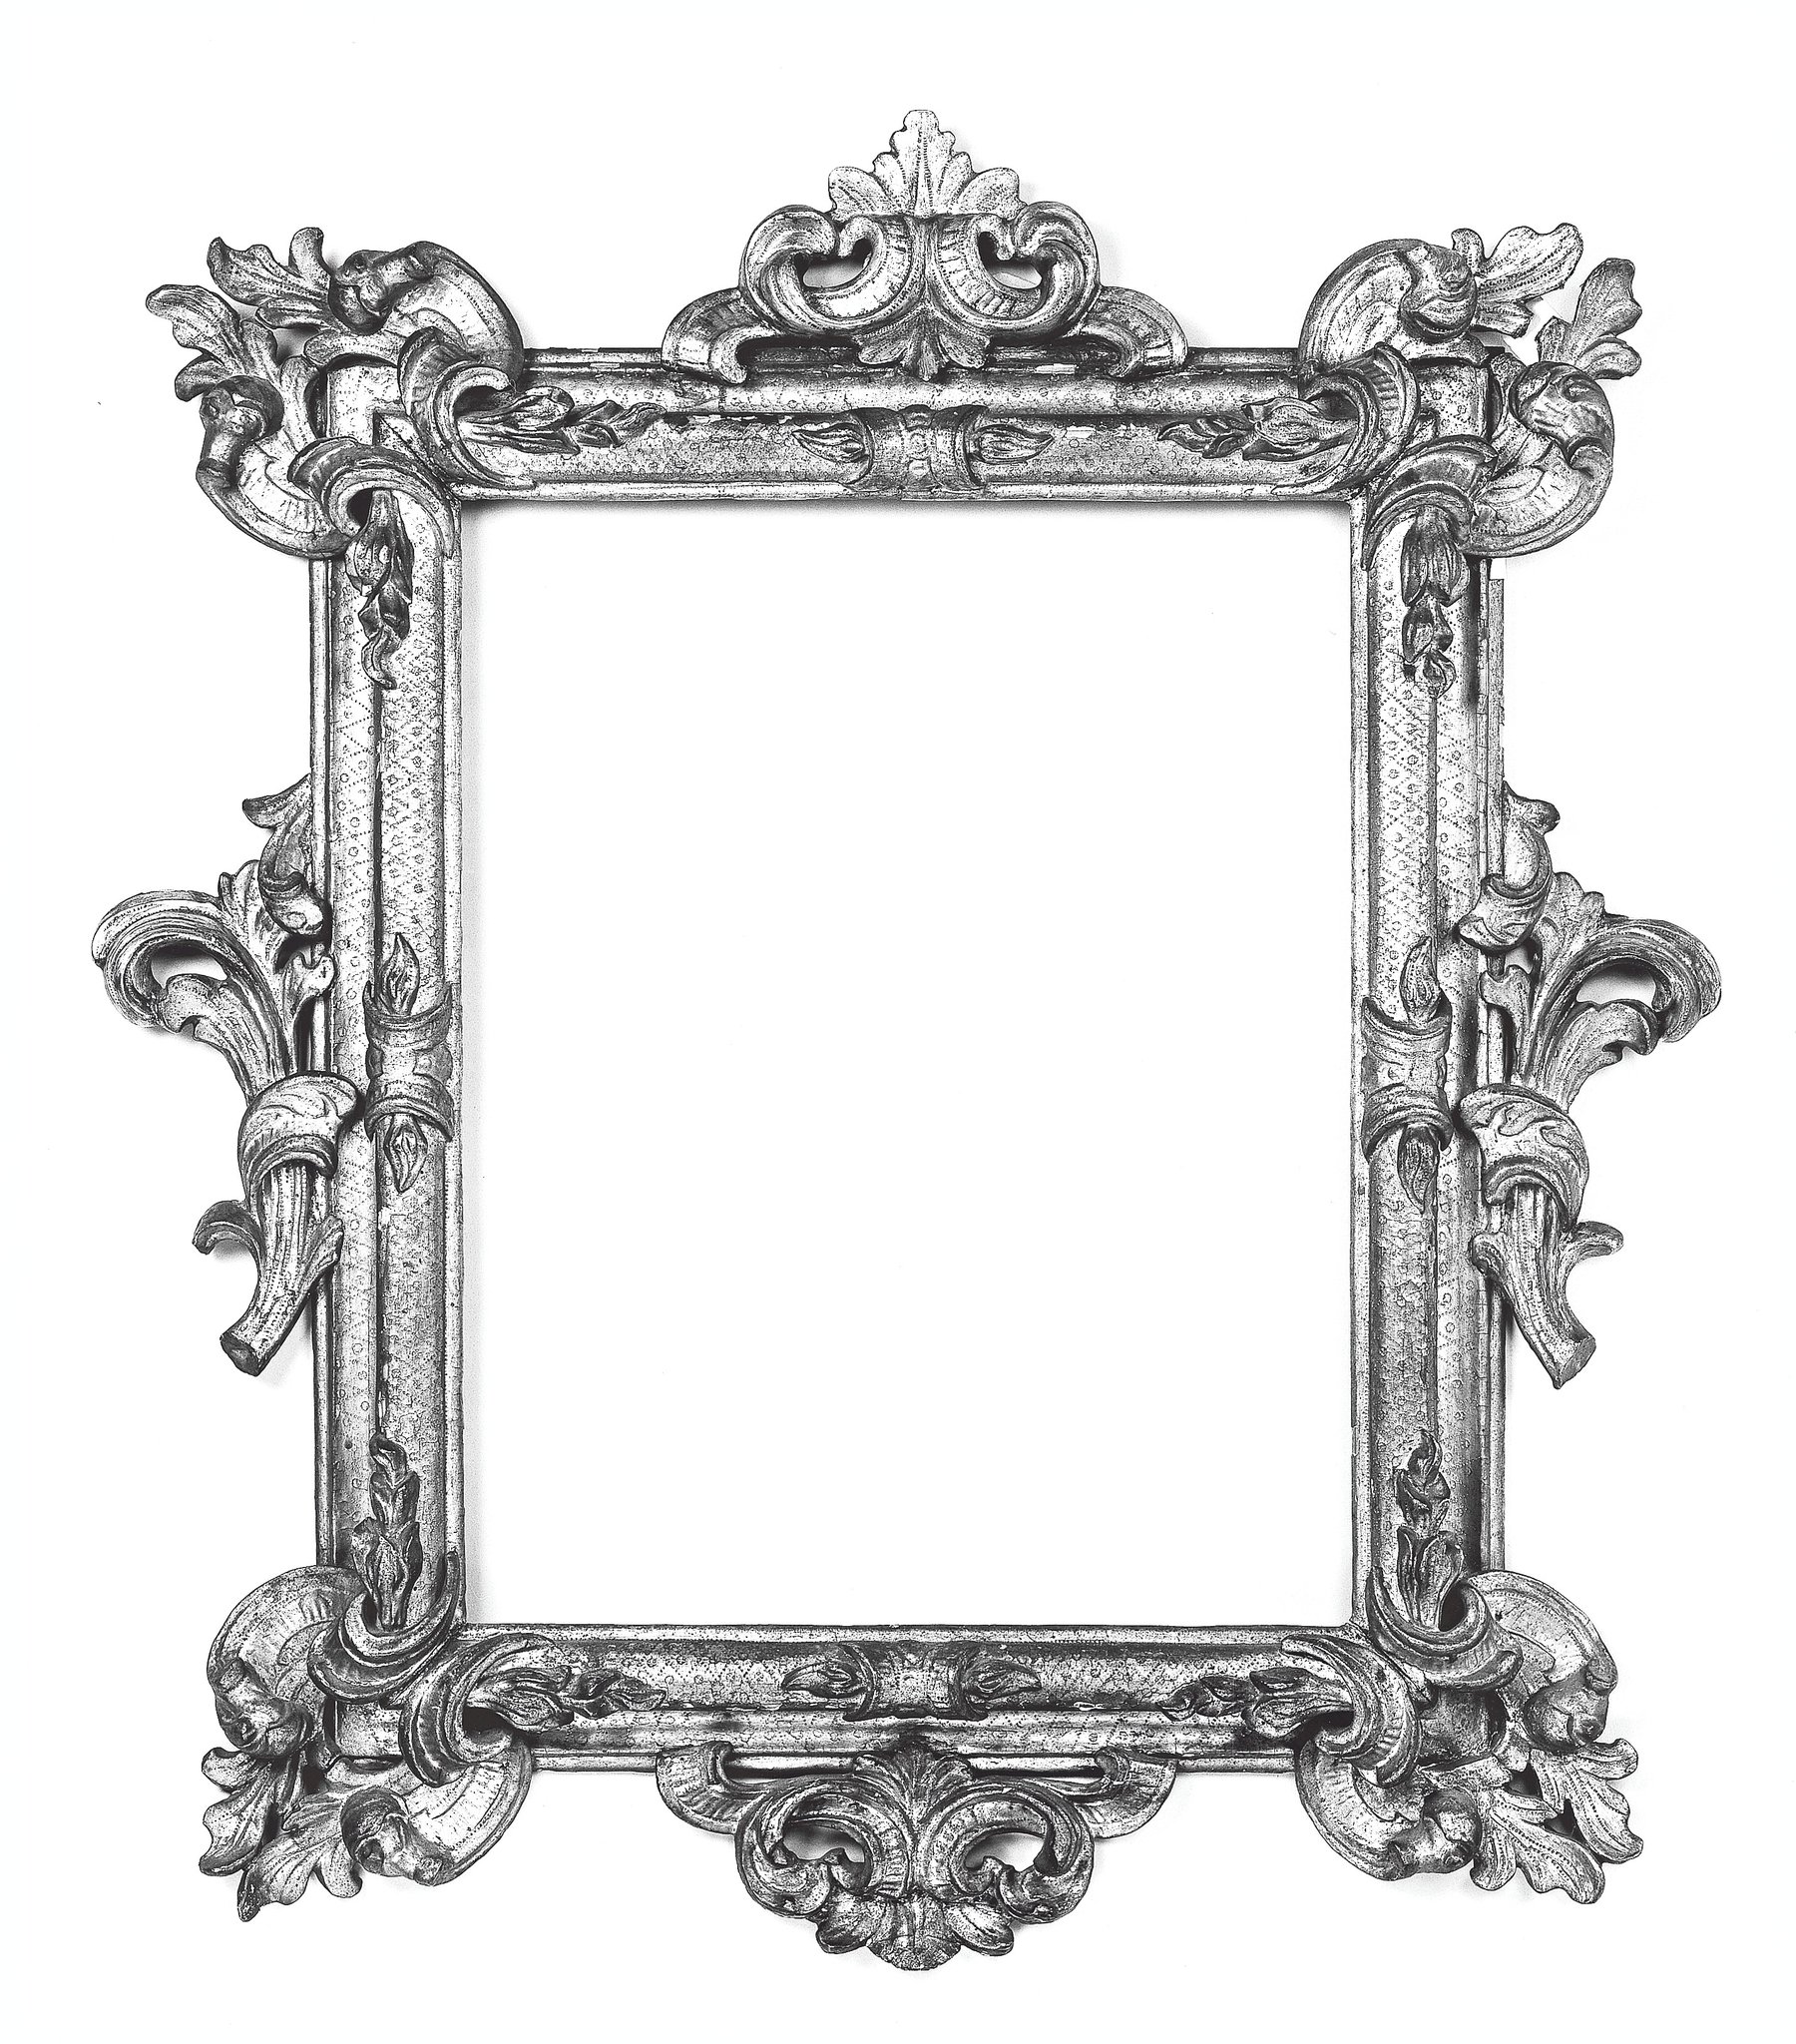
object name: frame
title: High Baroque frame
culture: italian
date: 1700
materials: wood